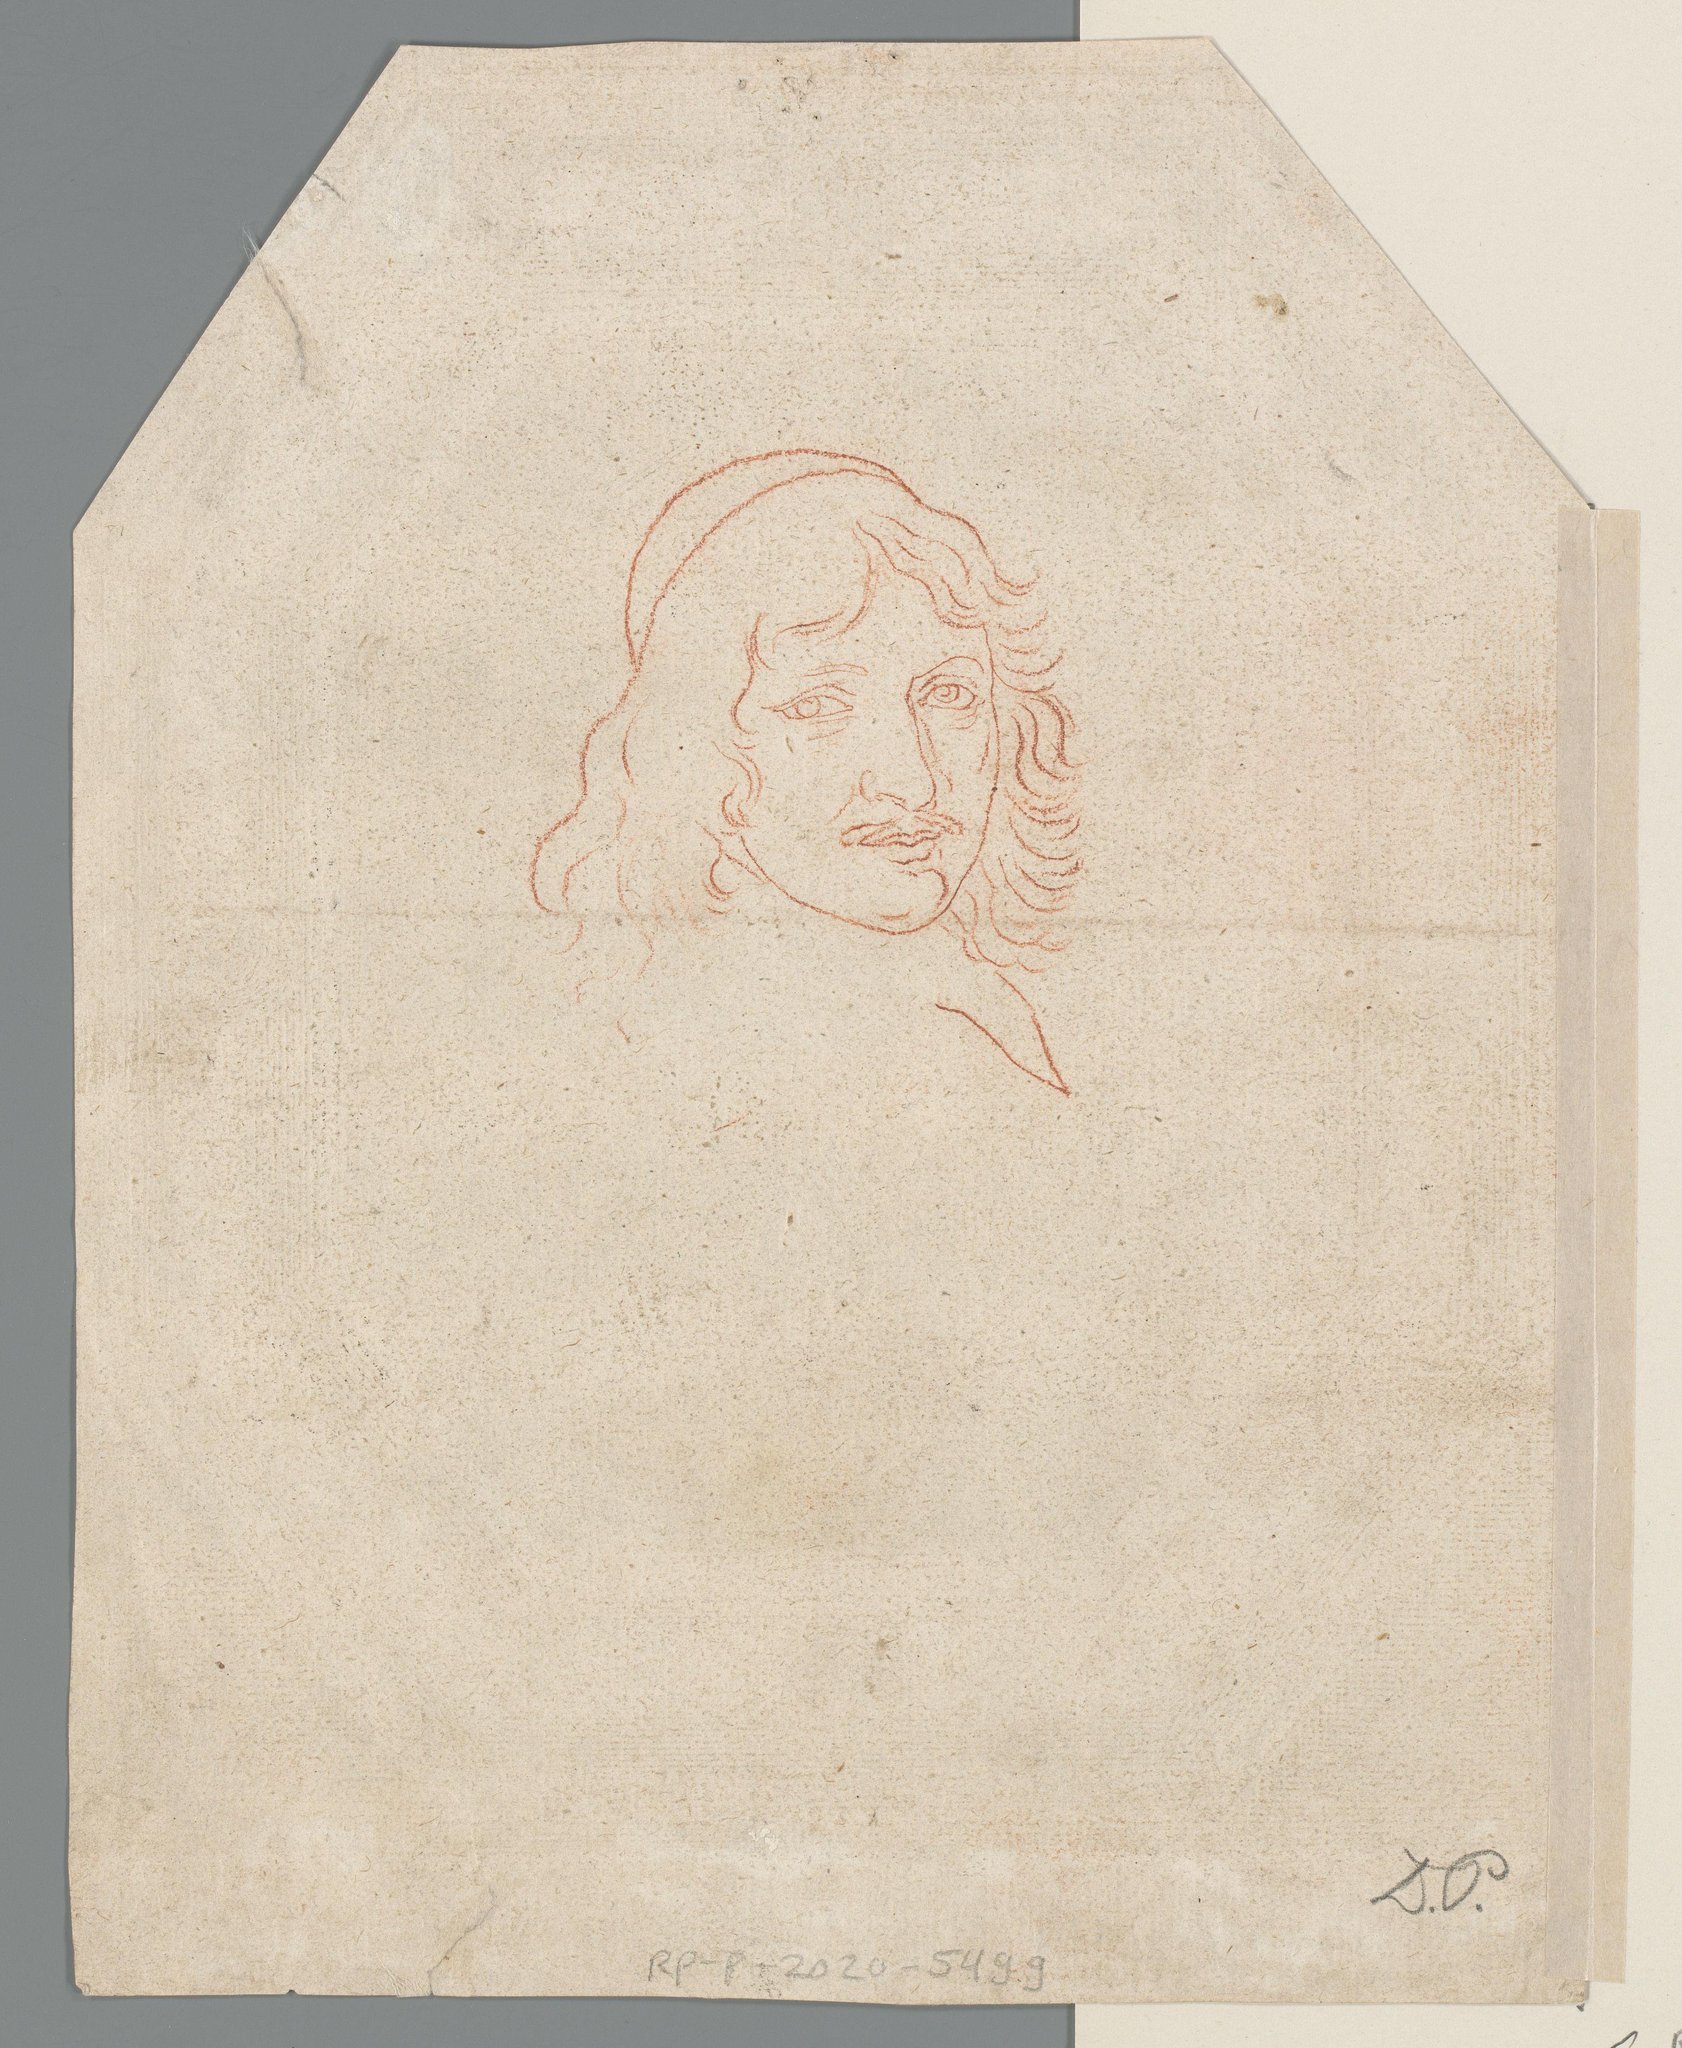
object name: drawing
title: Portret van Nicolas Fouquet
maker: Anonymous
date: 1653-1750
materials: chalk, paper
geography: france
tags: paris, france, politician, nicolas fouquet, historical persons, politician, e.g. party leader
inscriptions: monogram: ‘D.G.’